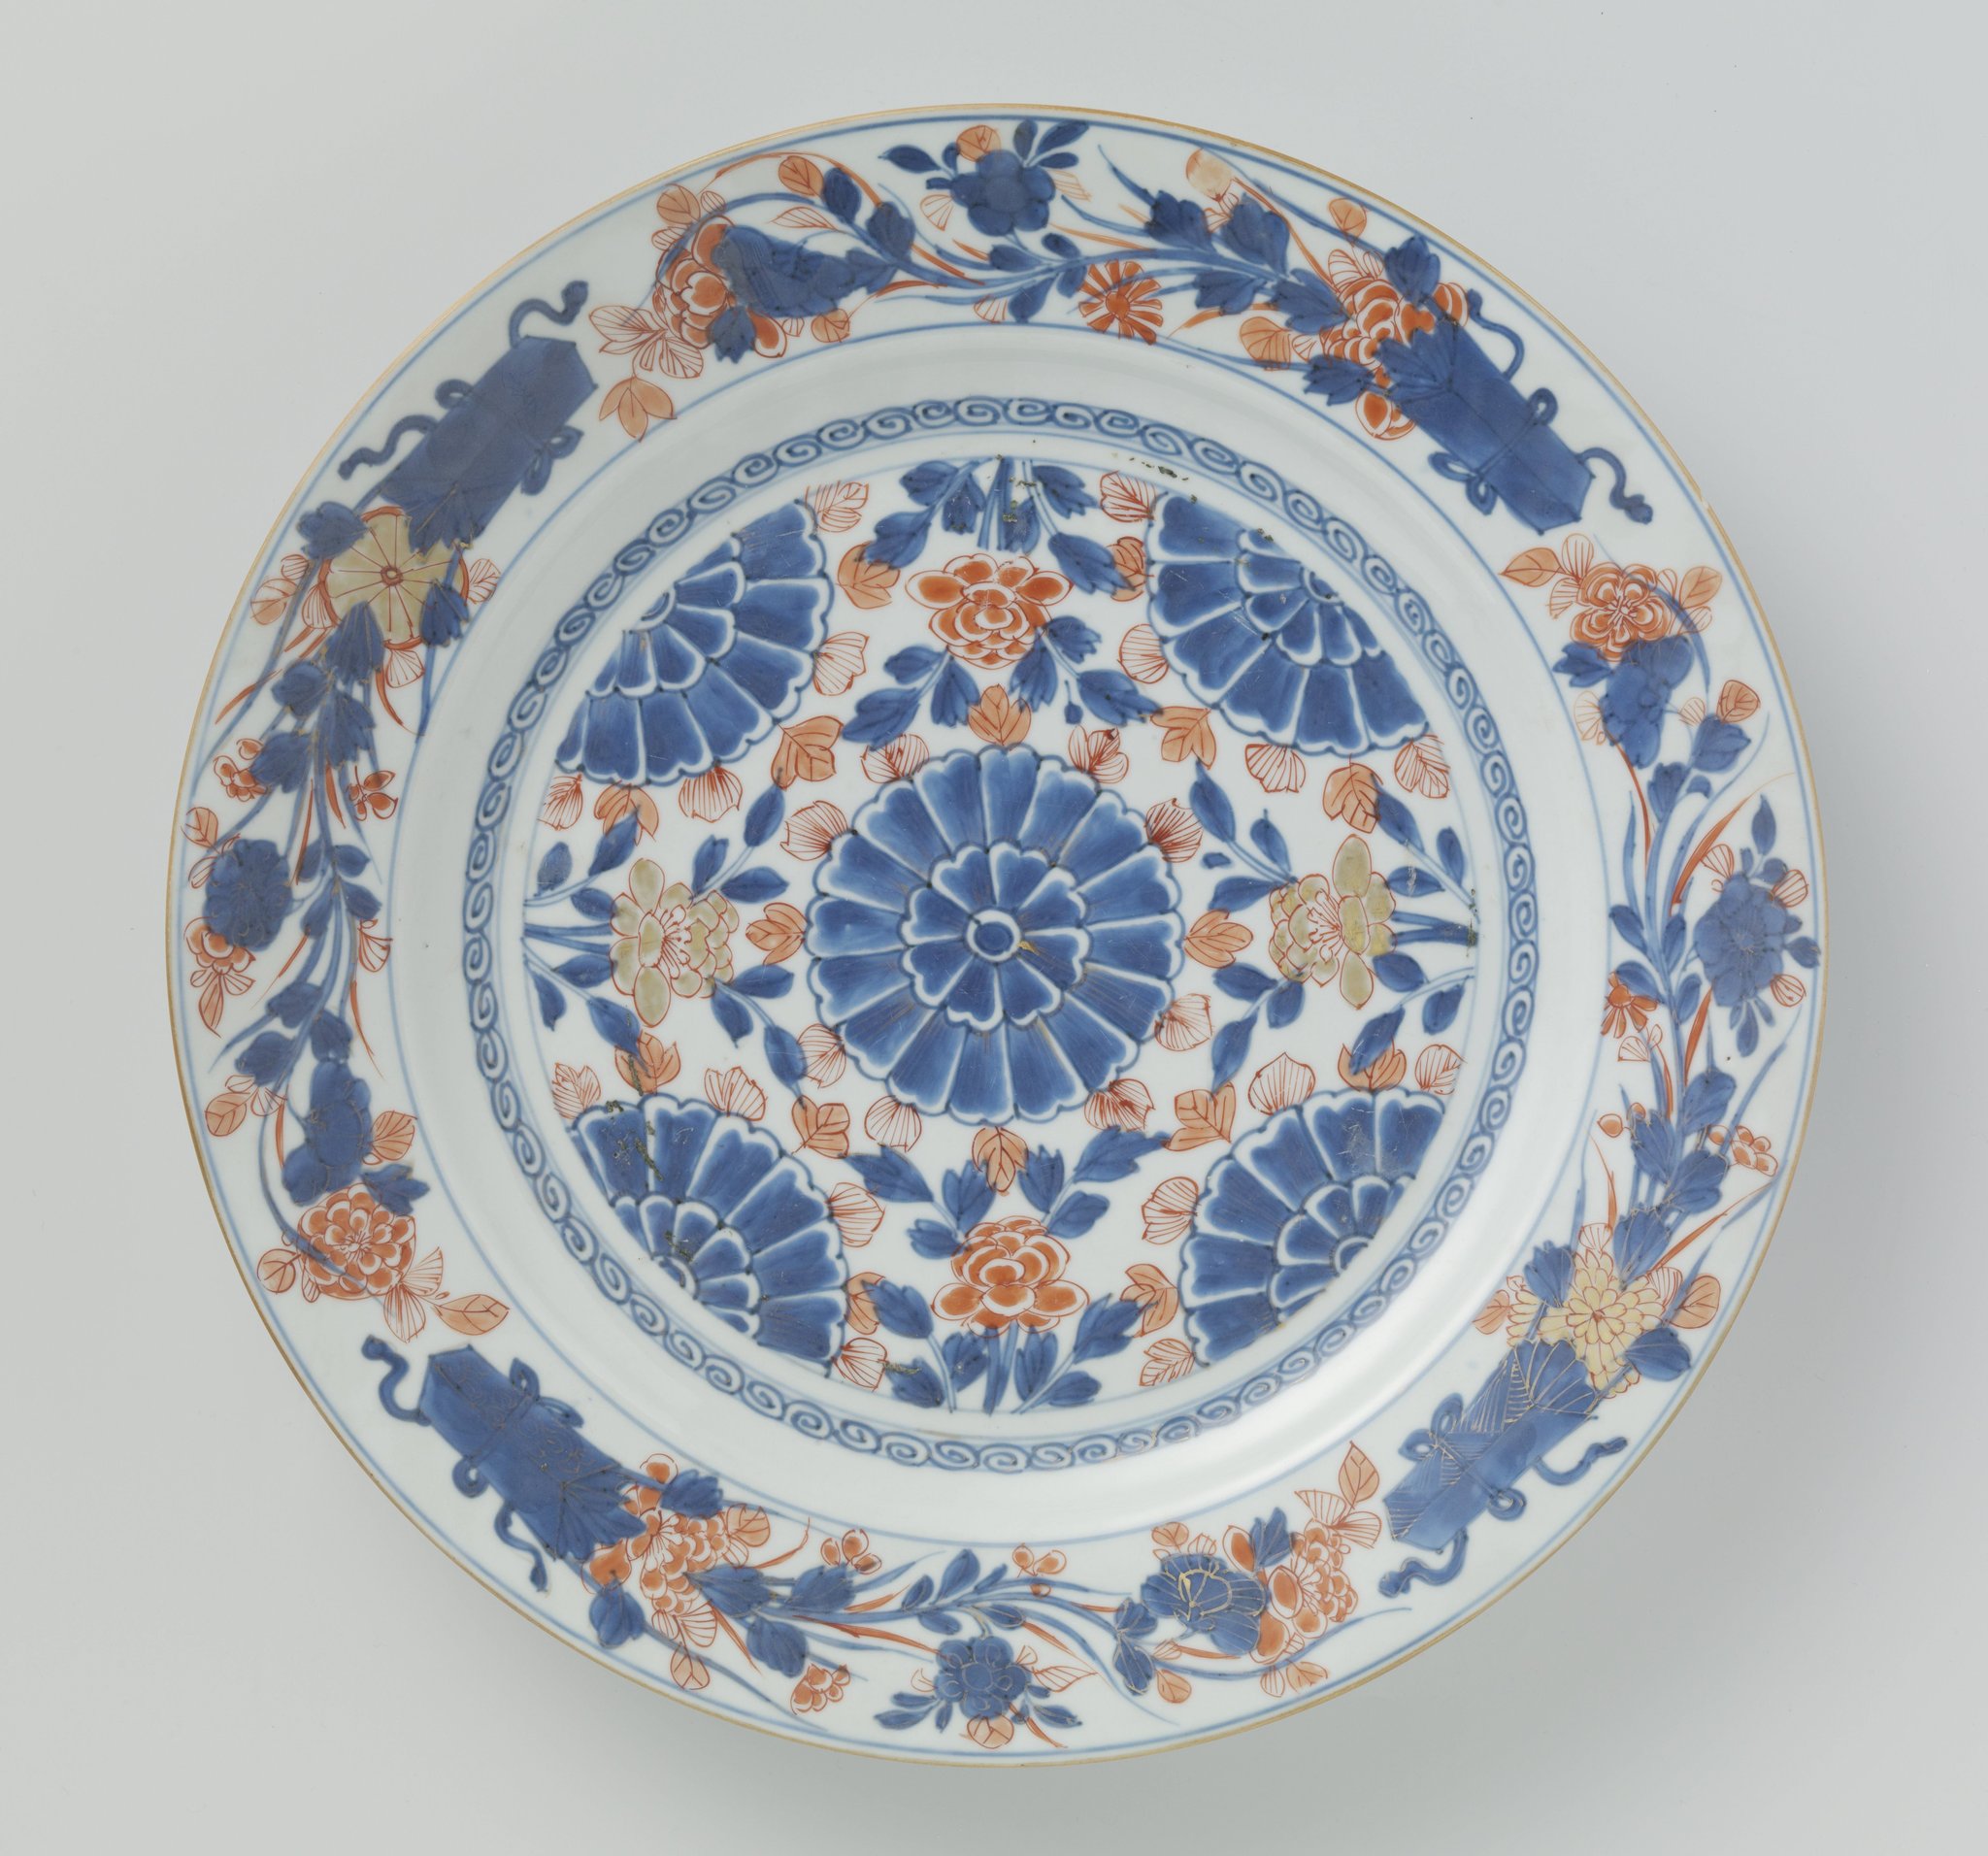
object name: platter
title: Dish with stylized flower heads, flower sprays and bouquets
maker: Anonymous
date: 1700-1724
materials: cobalt, glaze, paint, porcelain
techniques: firing, gilding, turning, vitrification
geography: china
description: Bord, gedecoreerd in Chinees Imari-kleuren. Bloemtakken, boeketten.